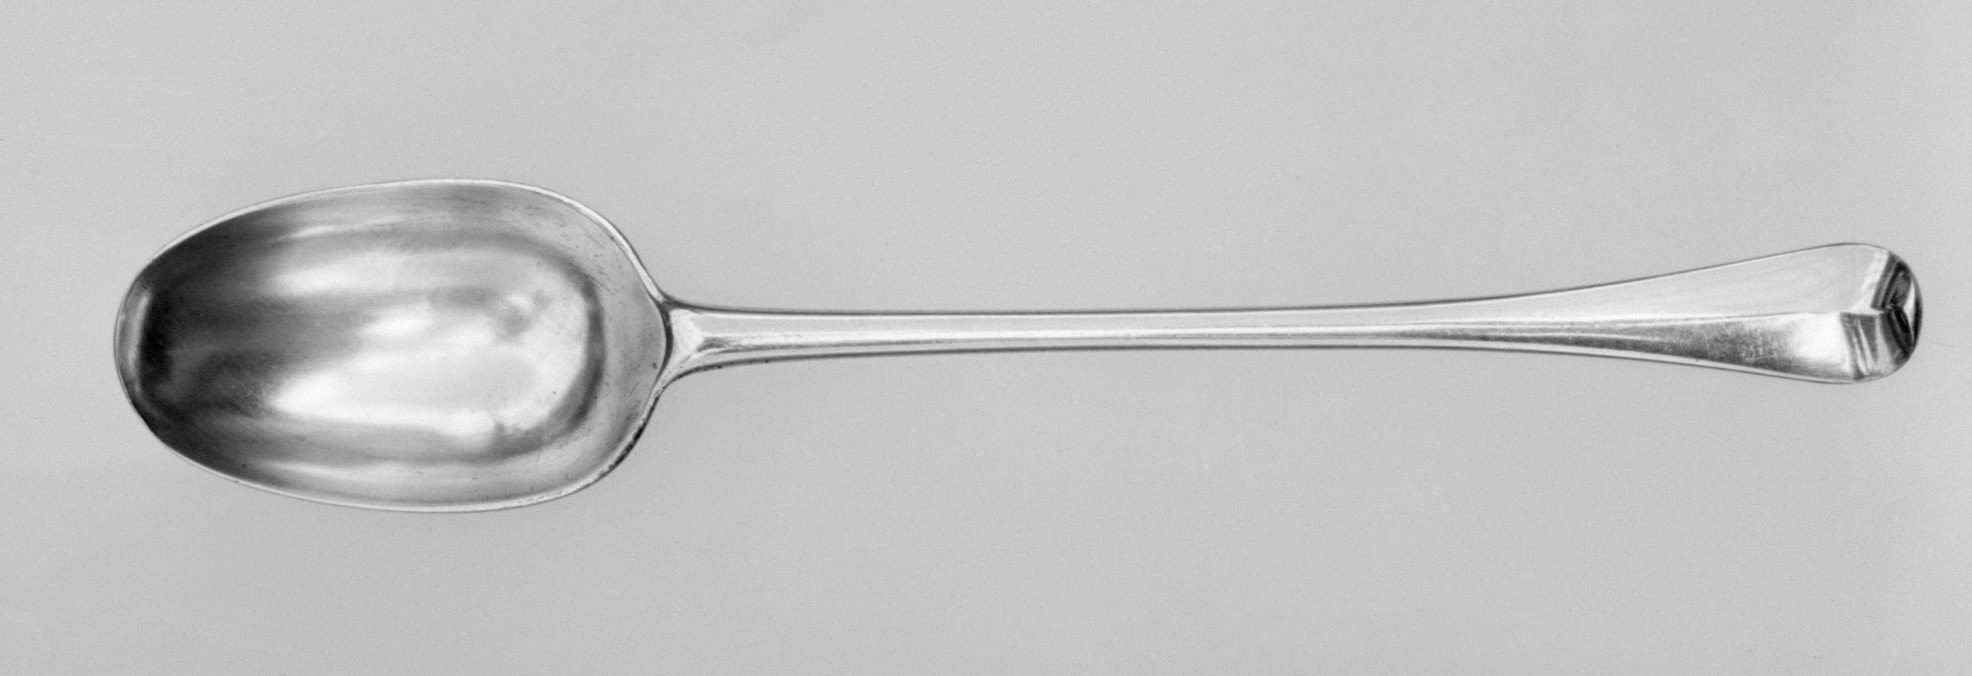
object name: spoon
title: Serving spoon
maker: lewis mettayer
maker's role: maker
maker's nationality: british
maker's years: 1640-1740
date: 1711-1712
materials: silver